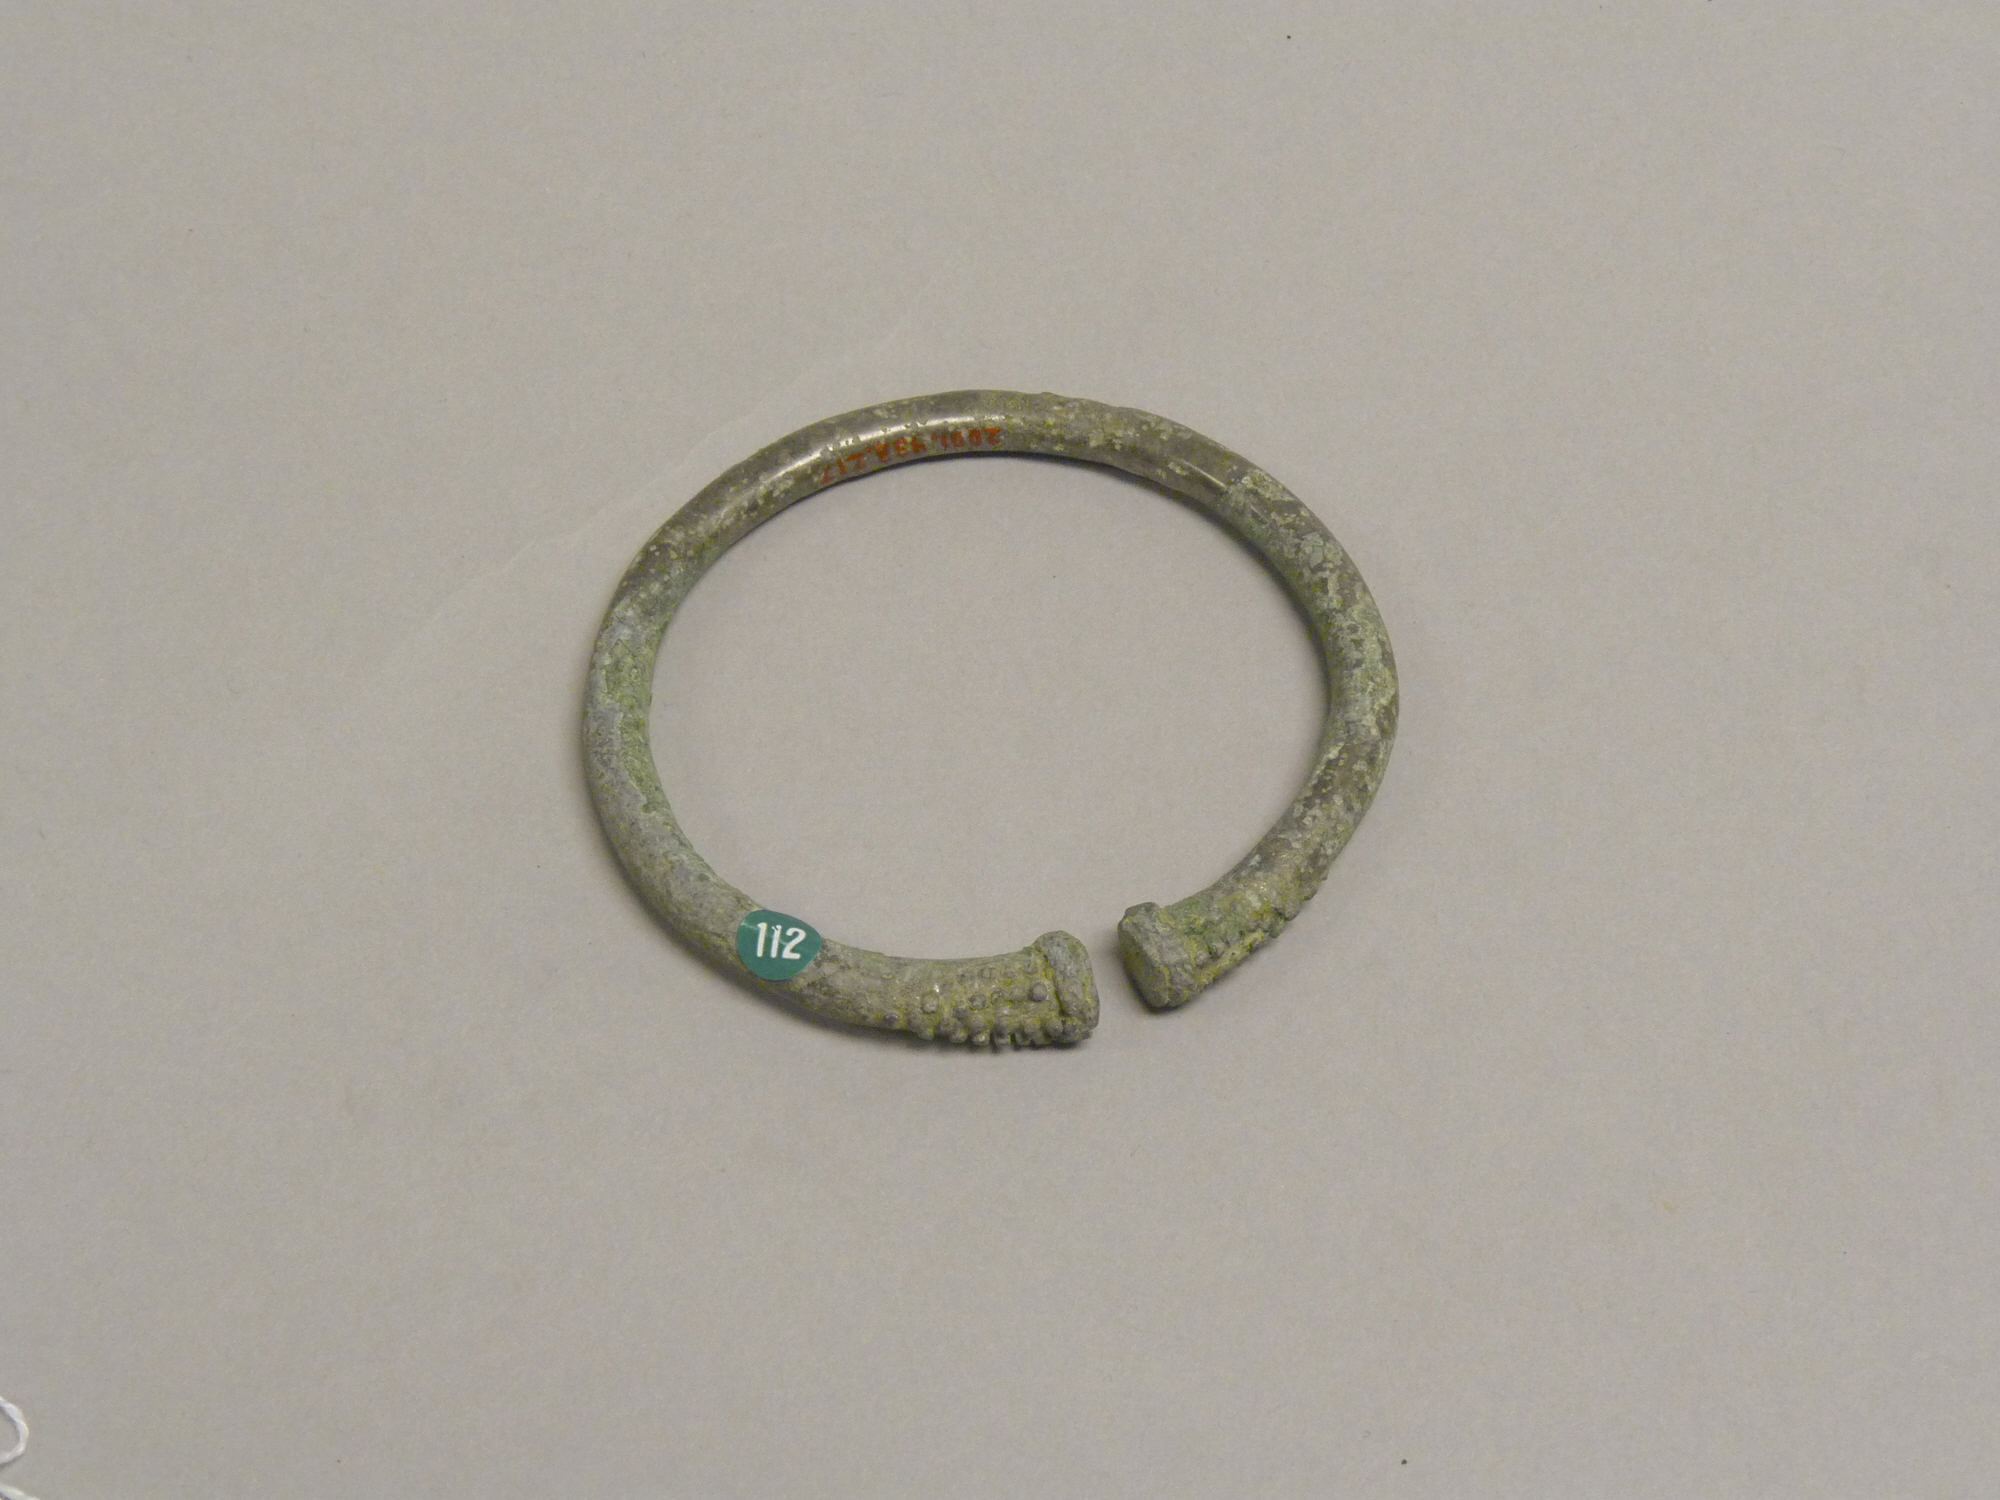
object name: bangle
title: Open Solid Bangle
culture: thai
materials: bronze